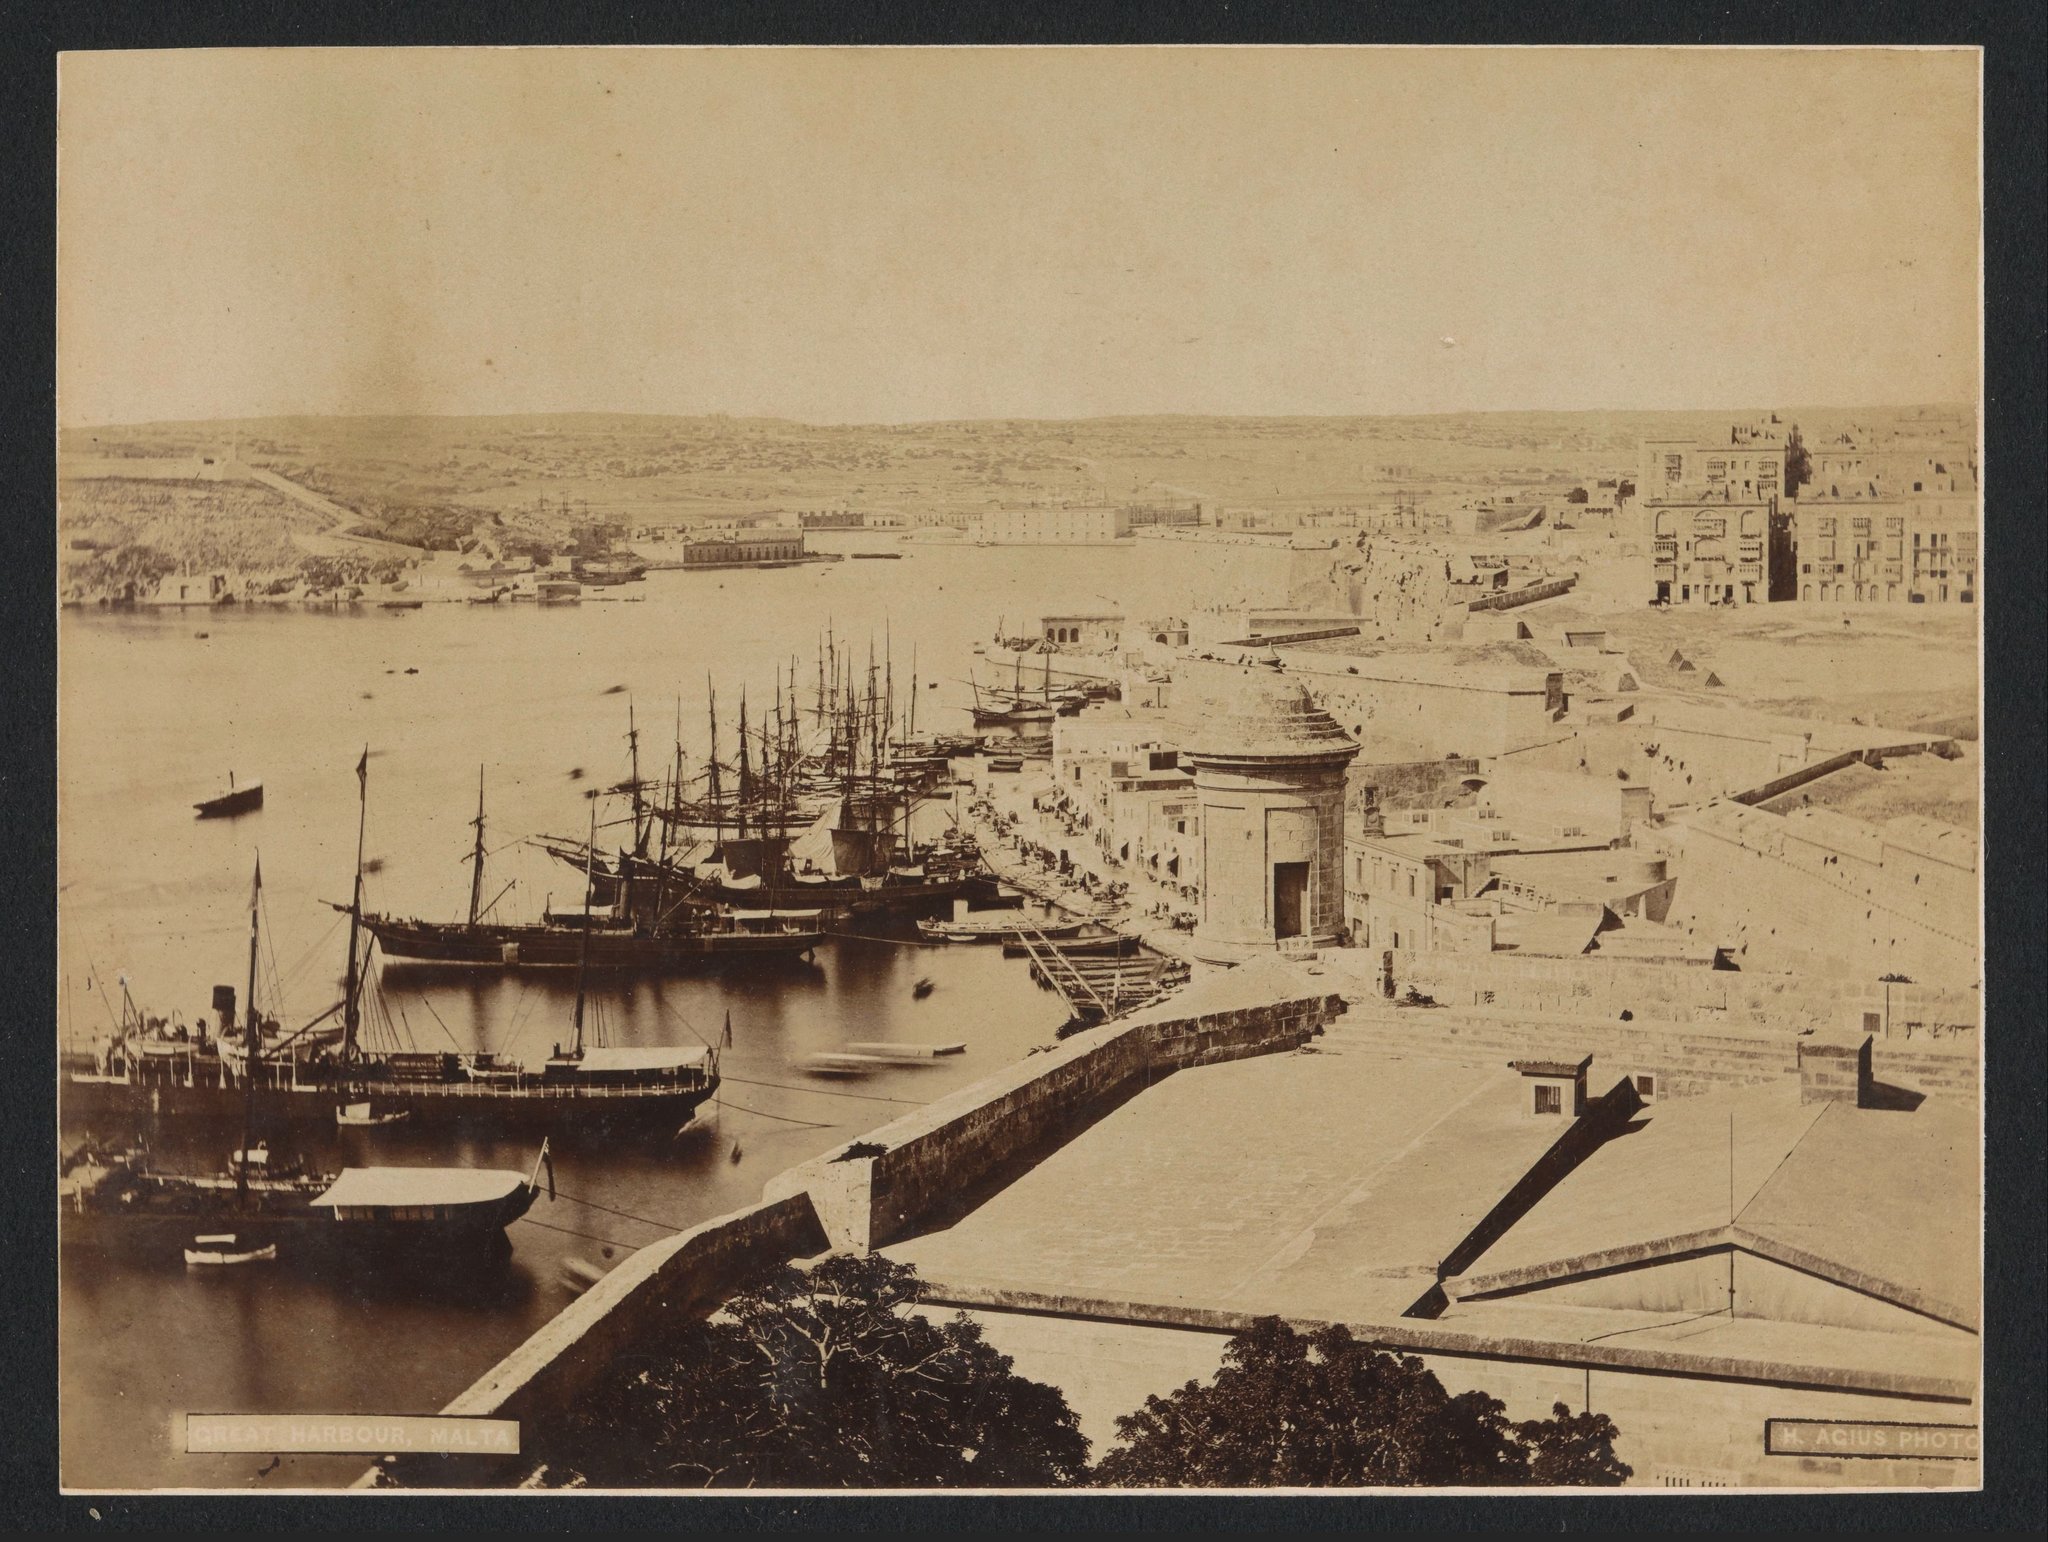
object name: photograph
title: Great Harbour, Malta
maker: horatio agius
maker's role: fotograaf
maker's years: 1844-1910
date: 1860-1910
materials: paper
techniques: albumen print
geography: malta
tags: harbour